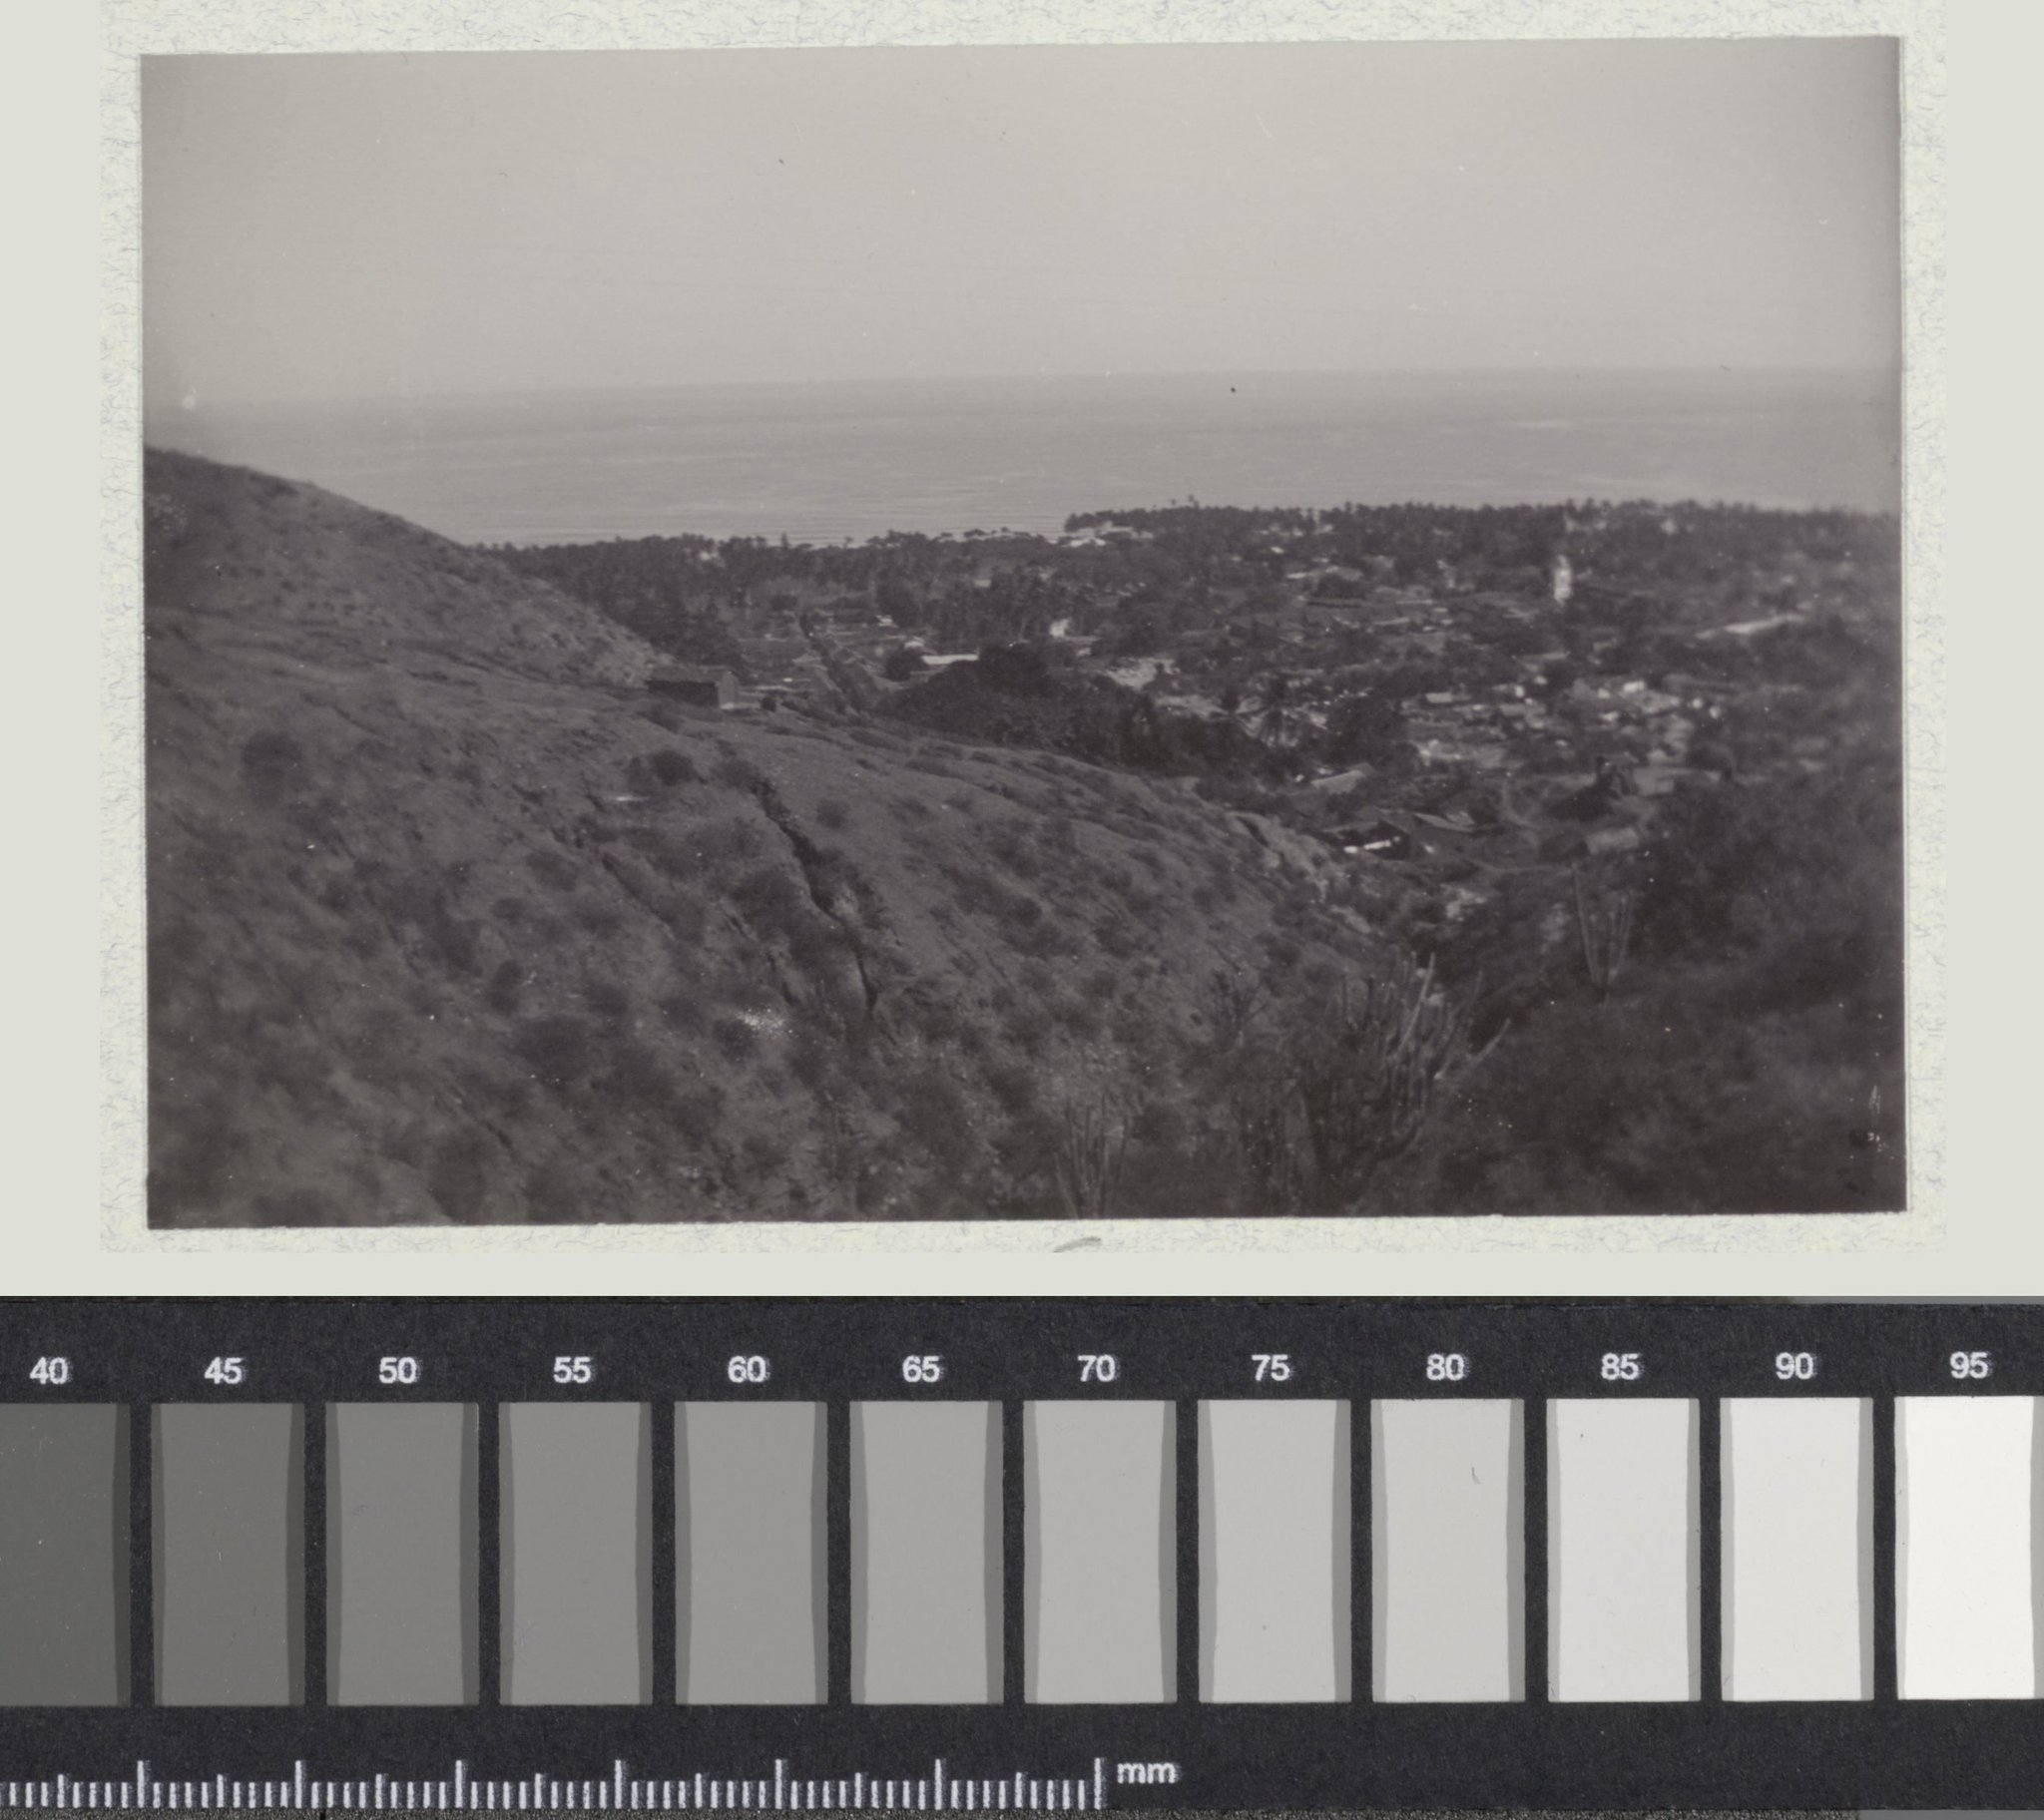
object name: photograph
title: La Guaira in Venezuela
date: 1902-1911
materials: photographic support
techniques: photography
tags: la guaira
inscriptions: inscription: ‘Gezicht op la Guaira Febr. 1911’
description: Gezicht op La Guaira in Venezuela, februari 1911. Onderdeel van het fotoalbum van de familie Boom-Gonggrijp in Suriname en Curaçao.